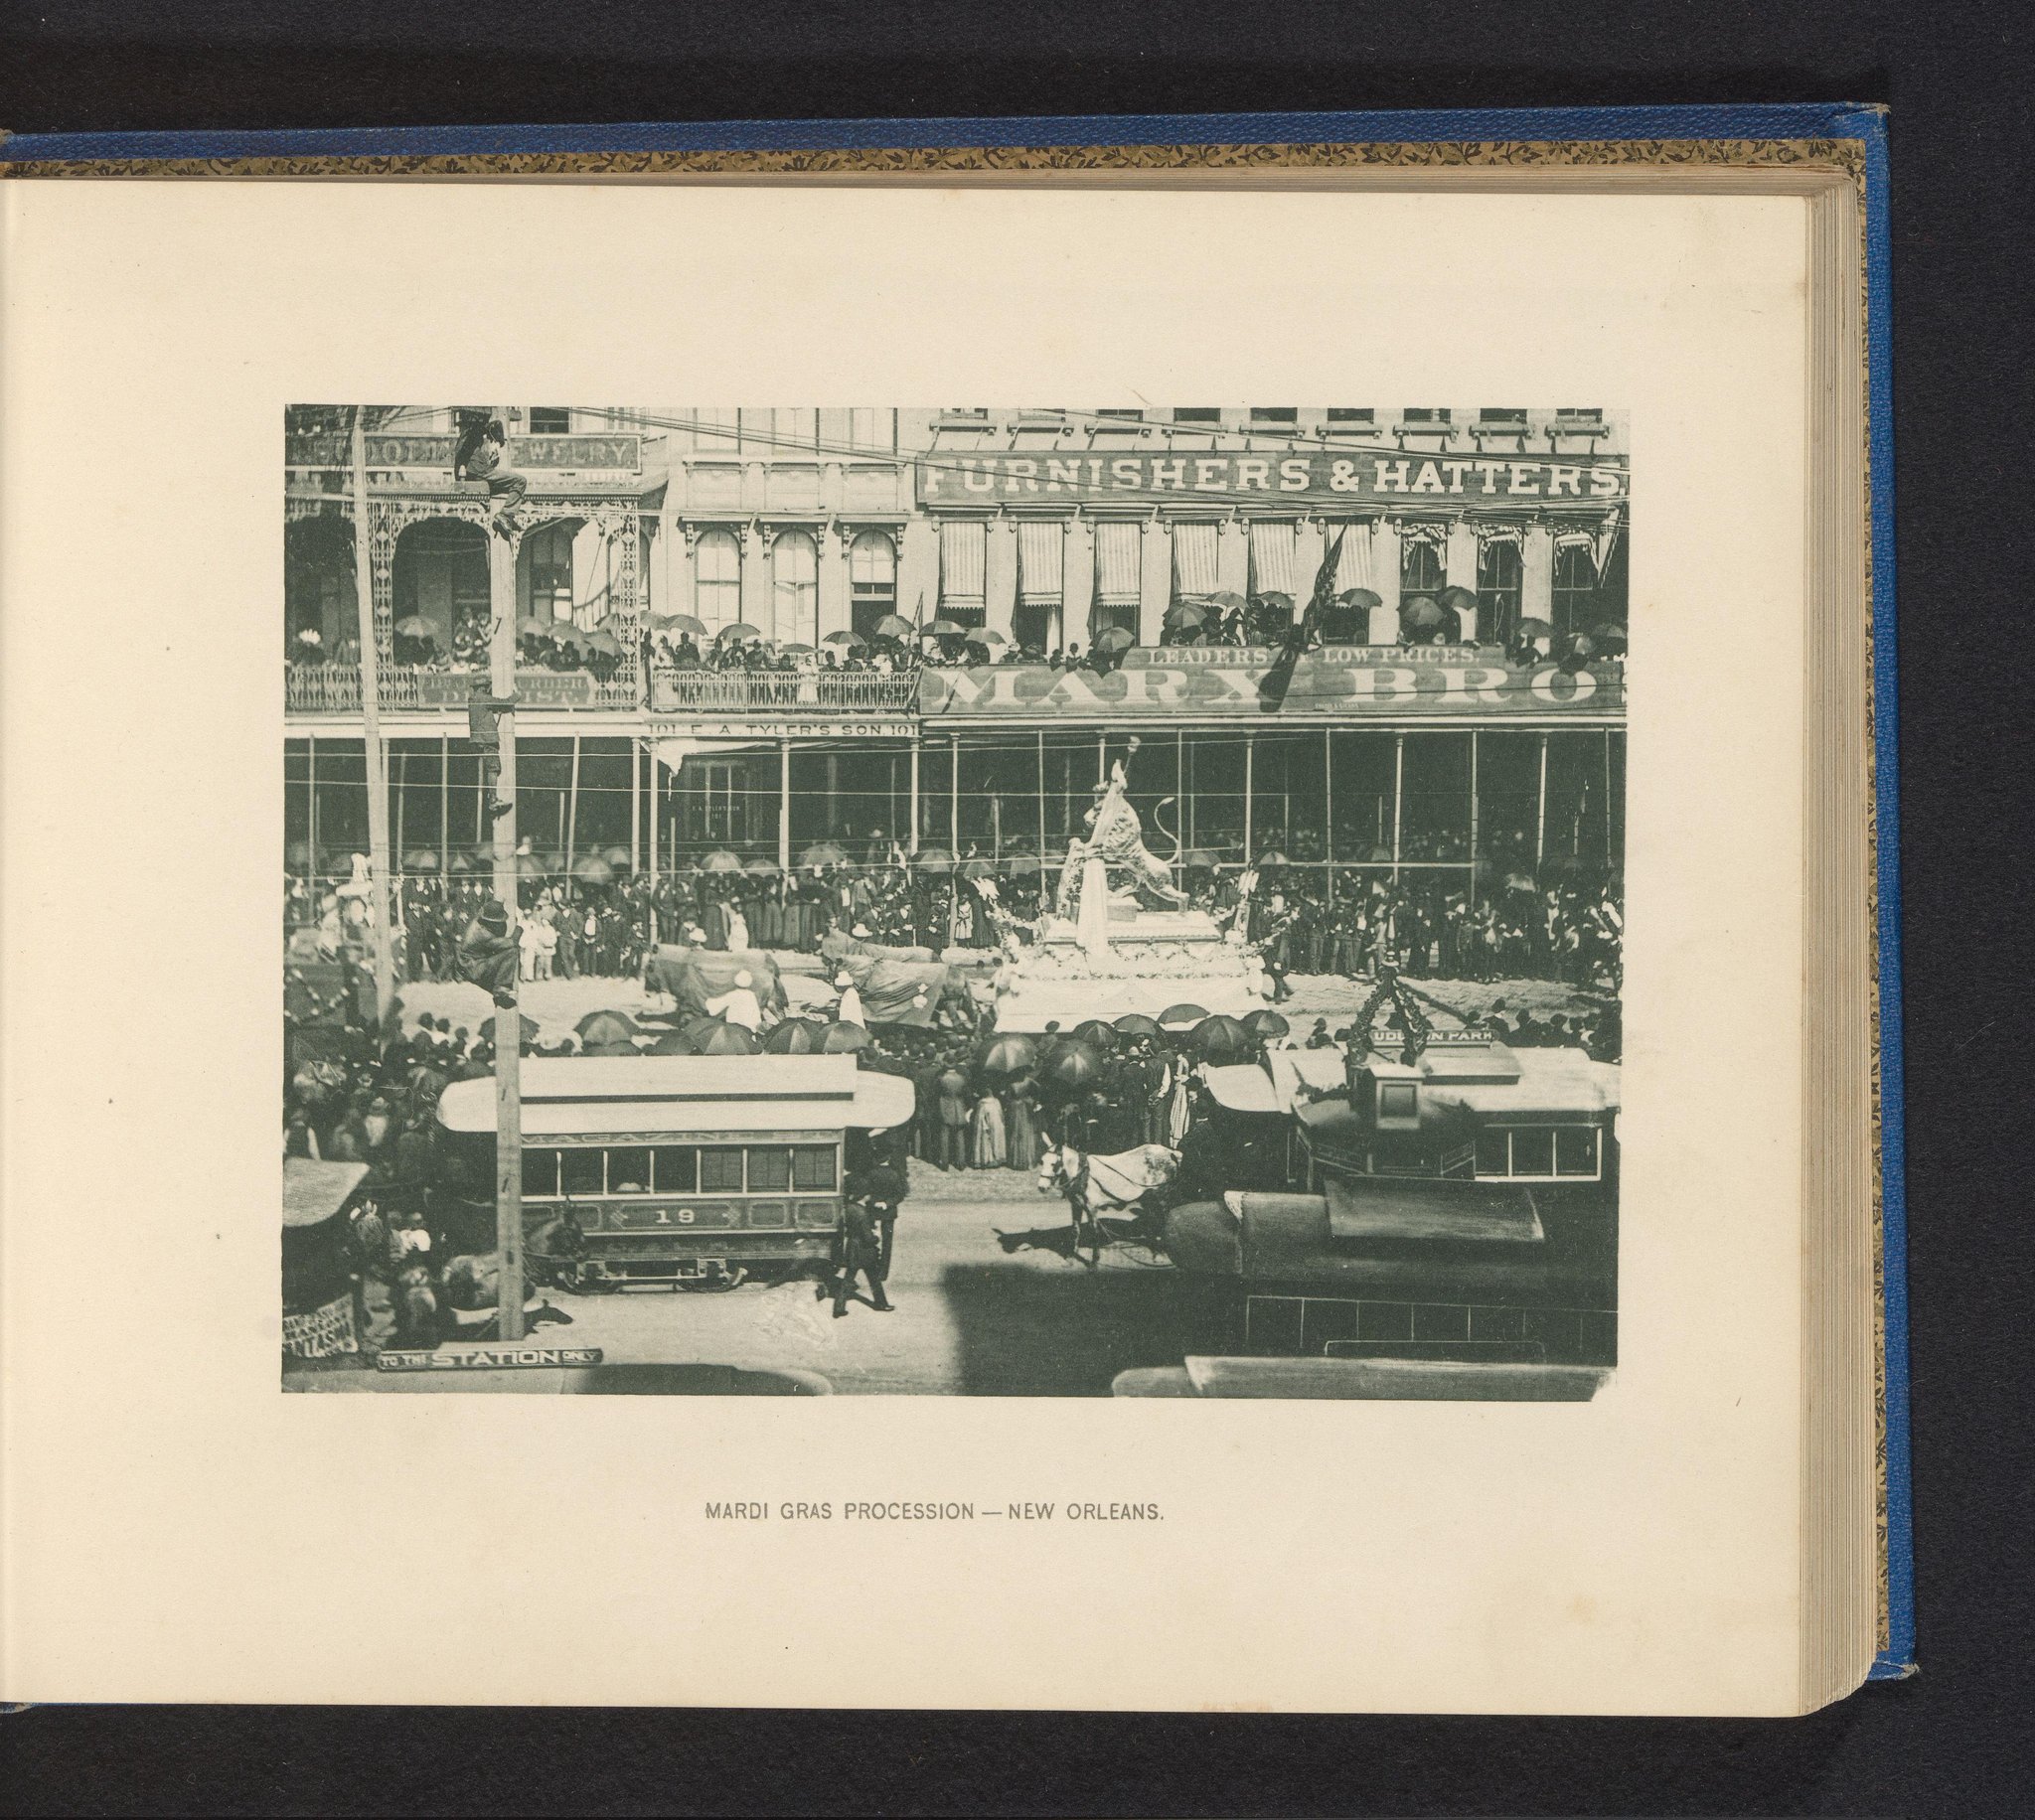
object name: photomechanical print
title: Mardi Gras optocht in New Orleans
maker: Anonymous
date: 1883-1893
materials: paper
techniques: photograph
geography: new orleans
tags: shrove tuesday, 'mardi gras' ~ non-liturgical celebrations of carnival